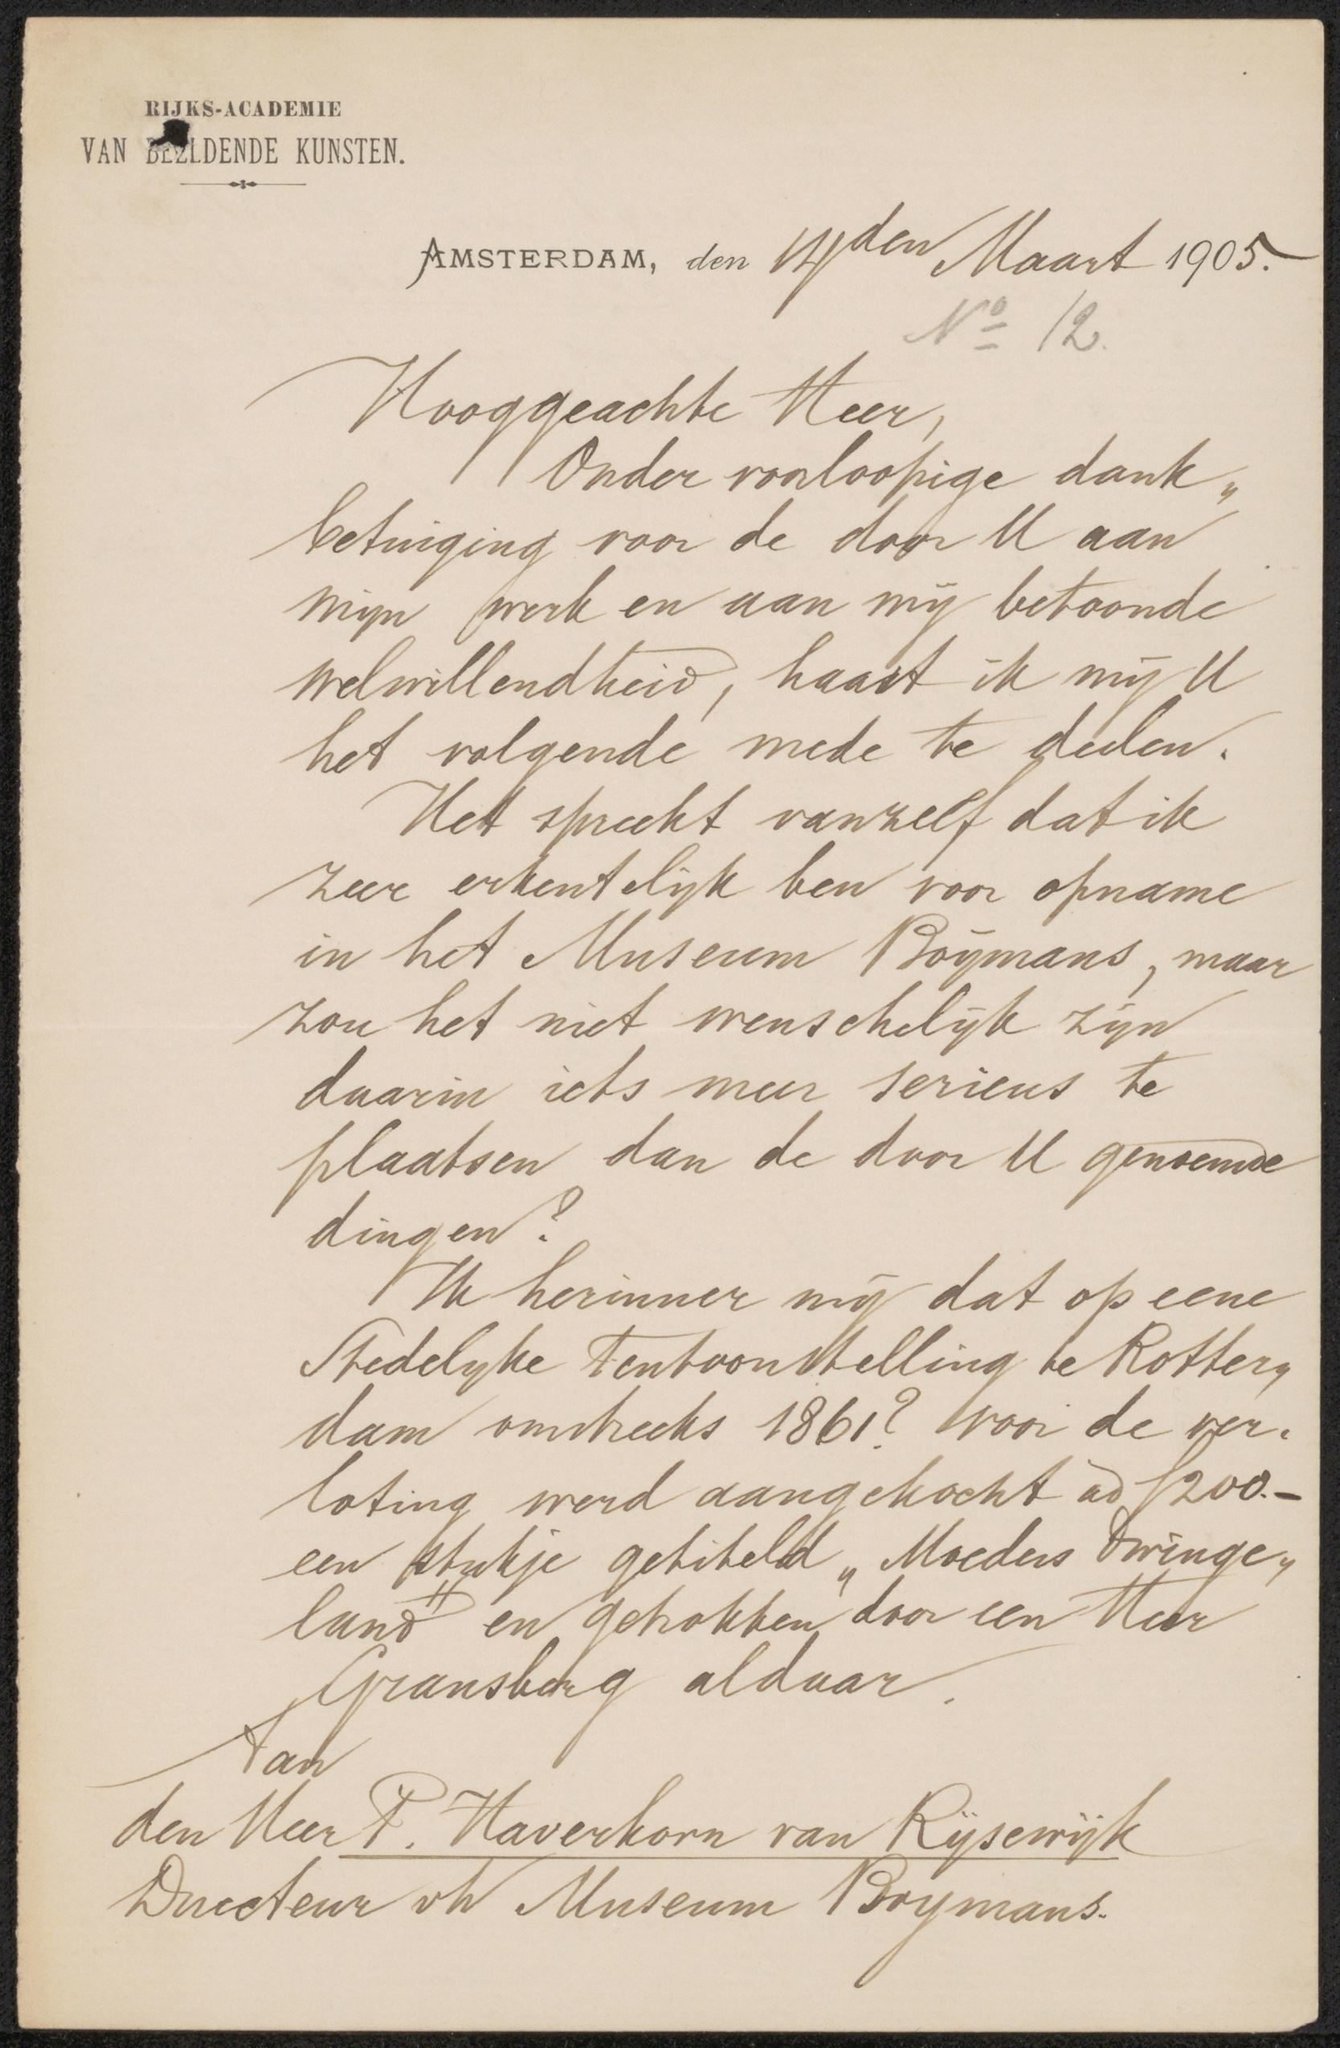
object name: letter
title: Brief aan Pieter Haverkorn van Rijsewijk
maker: august allebé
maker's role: draughtsman, print maker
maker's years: 1838-1927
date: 1905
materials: ink, paper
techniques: pen, printing, writing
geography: amsterdam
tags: pieter haverkorn van rijsewijk, exhibition ~ art, art collecting, rotterdam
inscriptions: collector's mark: Lugt 2233